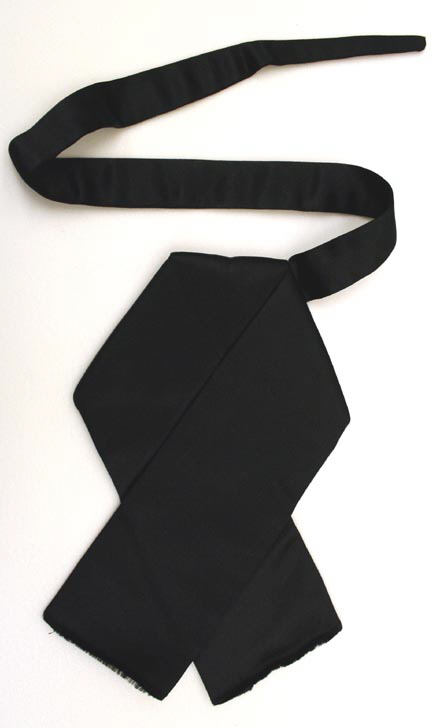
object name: cravat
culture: european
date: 1880-1889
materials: silk